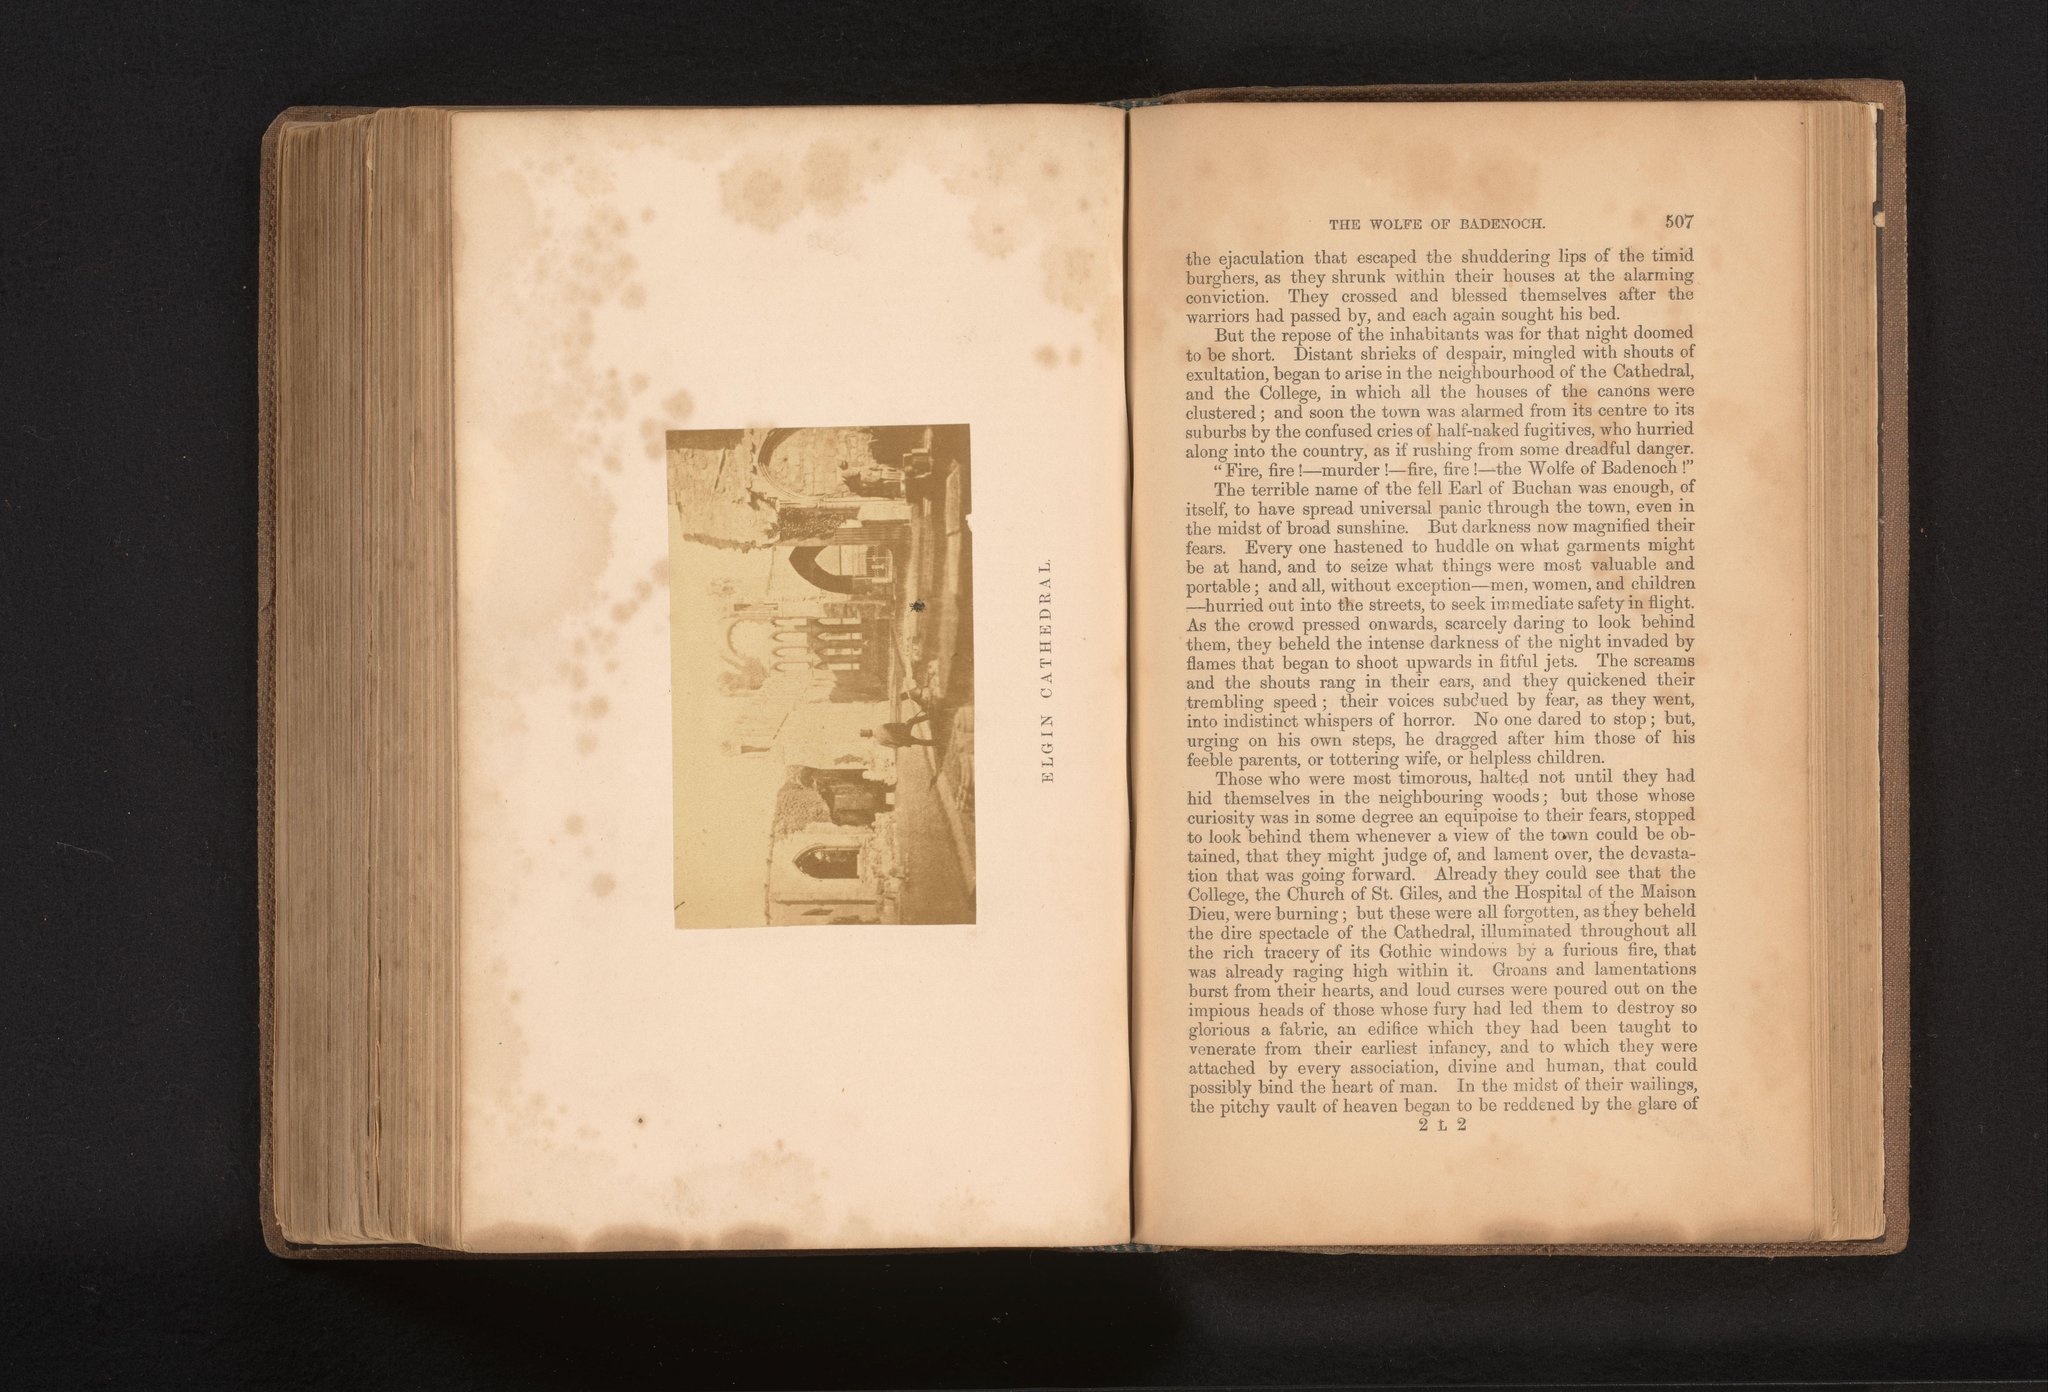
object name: page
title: Elgin Cathedral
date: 1858-1863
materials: photographic support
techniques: albumen print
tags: church (exterior)